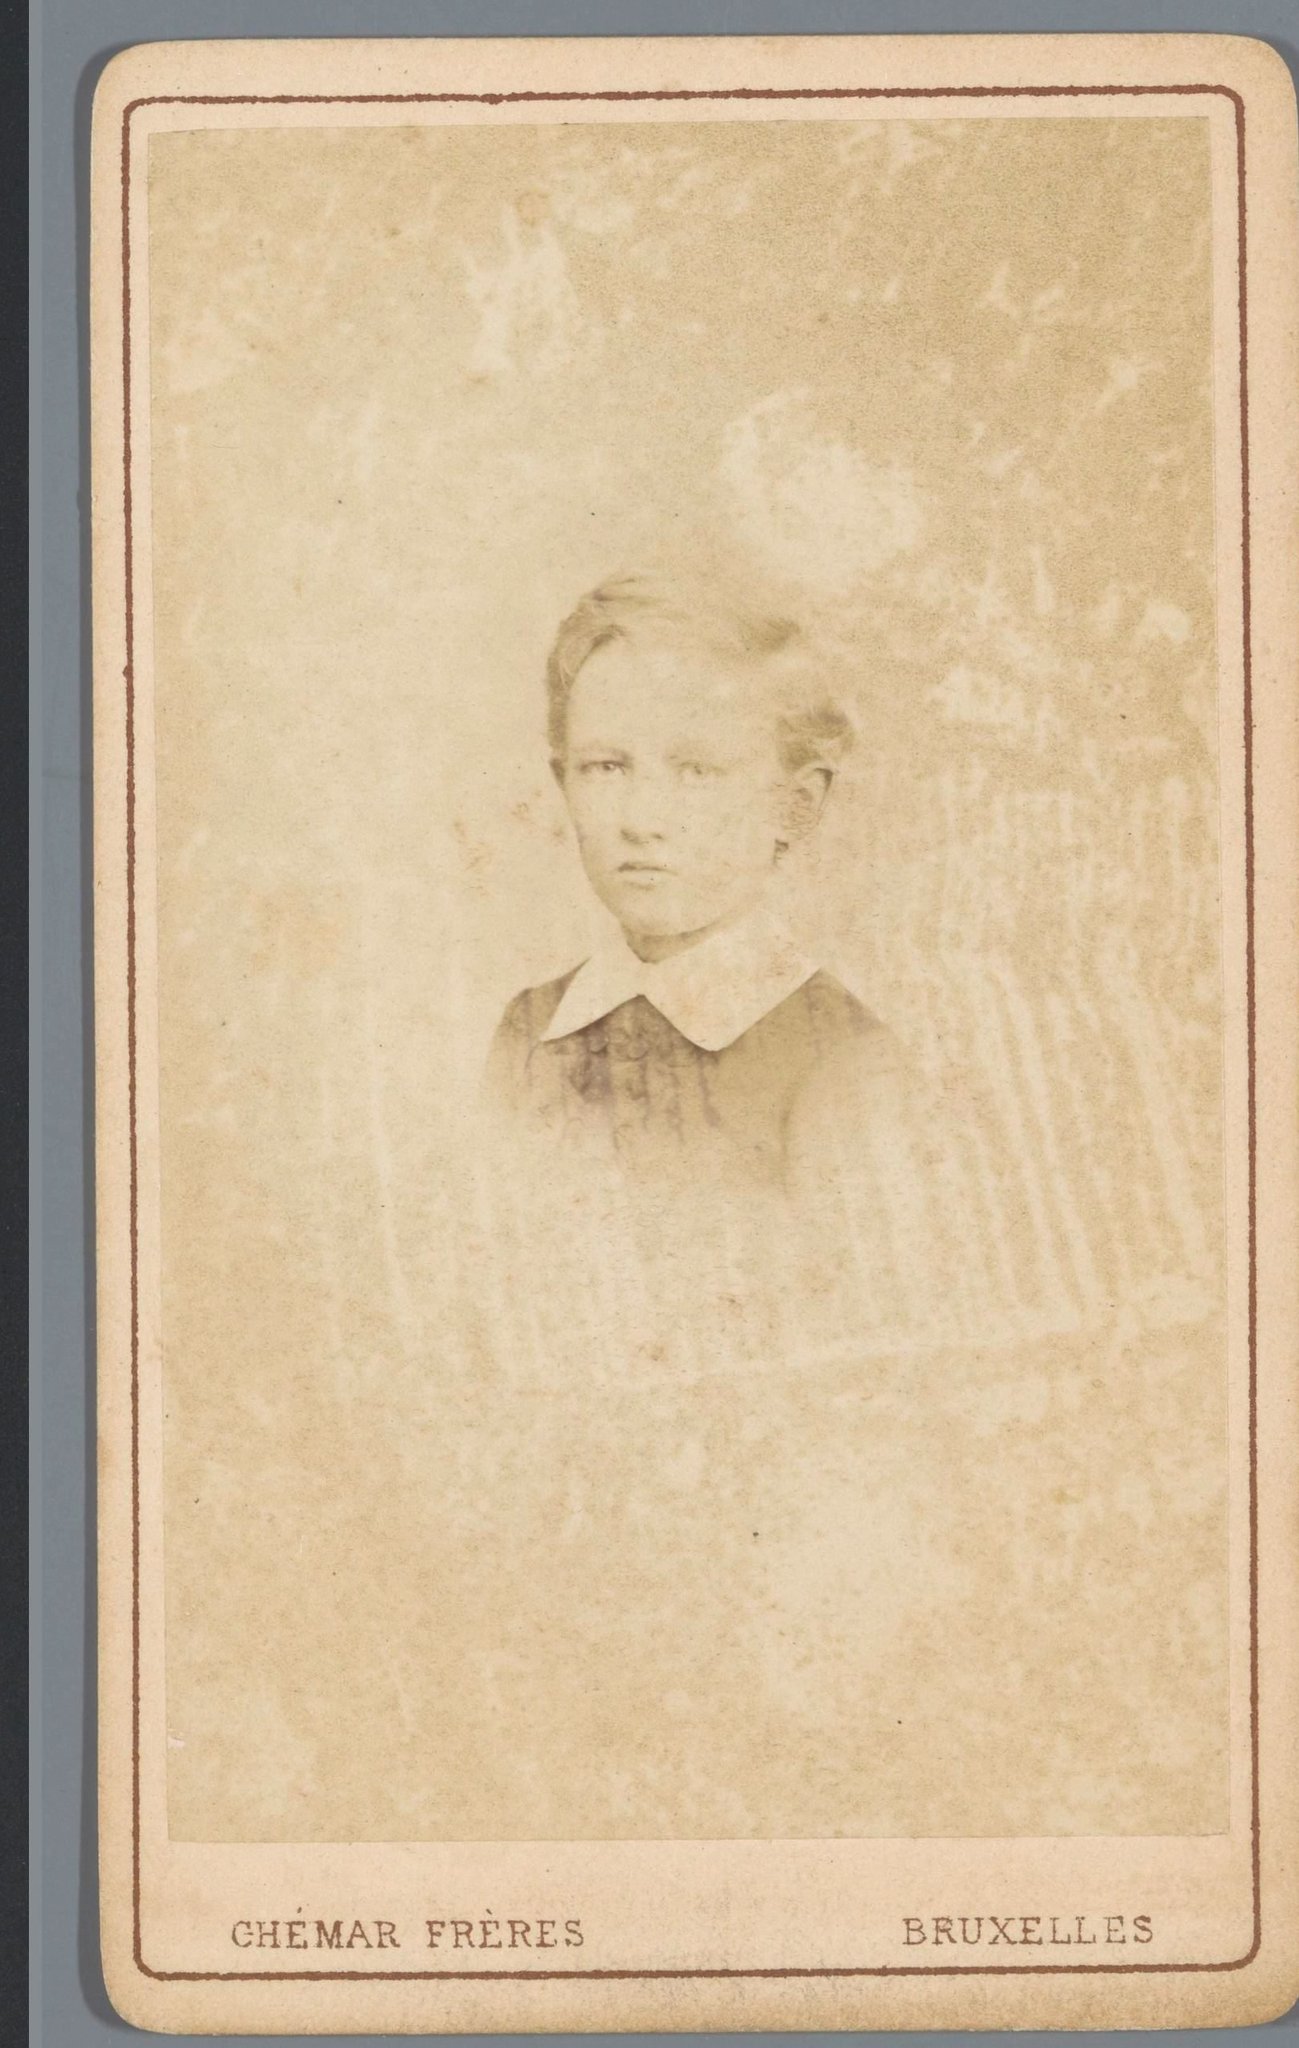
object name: carte de visite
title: Portret van een onbekende jongen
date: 1860-1894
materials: cardboard, paper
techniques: albumen print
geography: brussels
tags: boy (child between toddler and youth), historical persons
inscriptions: inscription: ‘GHÉMAR FRÈRES/ PHOTOGRAPHES DU ROI/ 27, Rue de l'Ecuyer, 27./ Entrée par la porte cochère/ BRUXELLES/ Les Clichés sont conservés indéfiniment.’